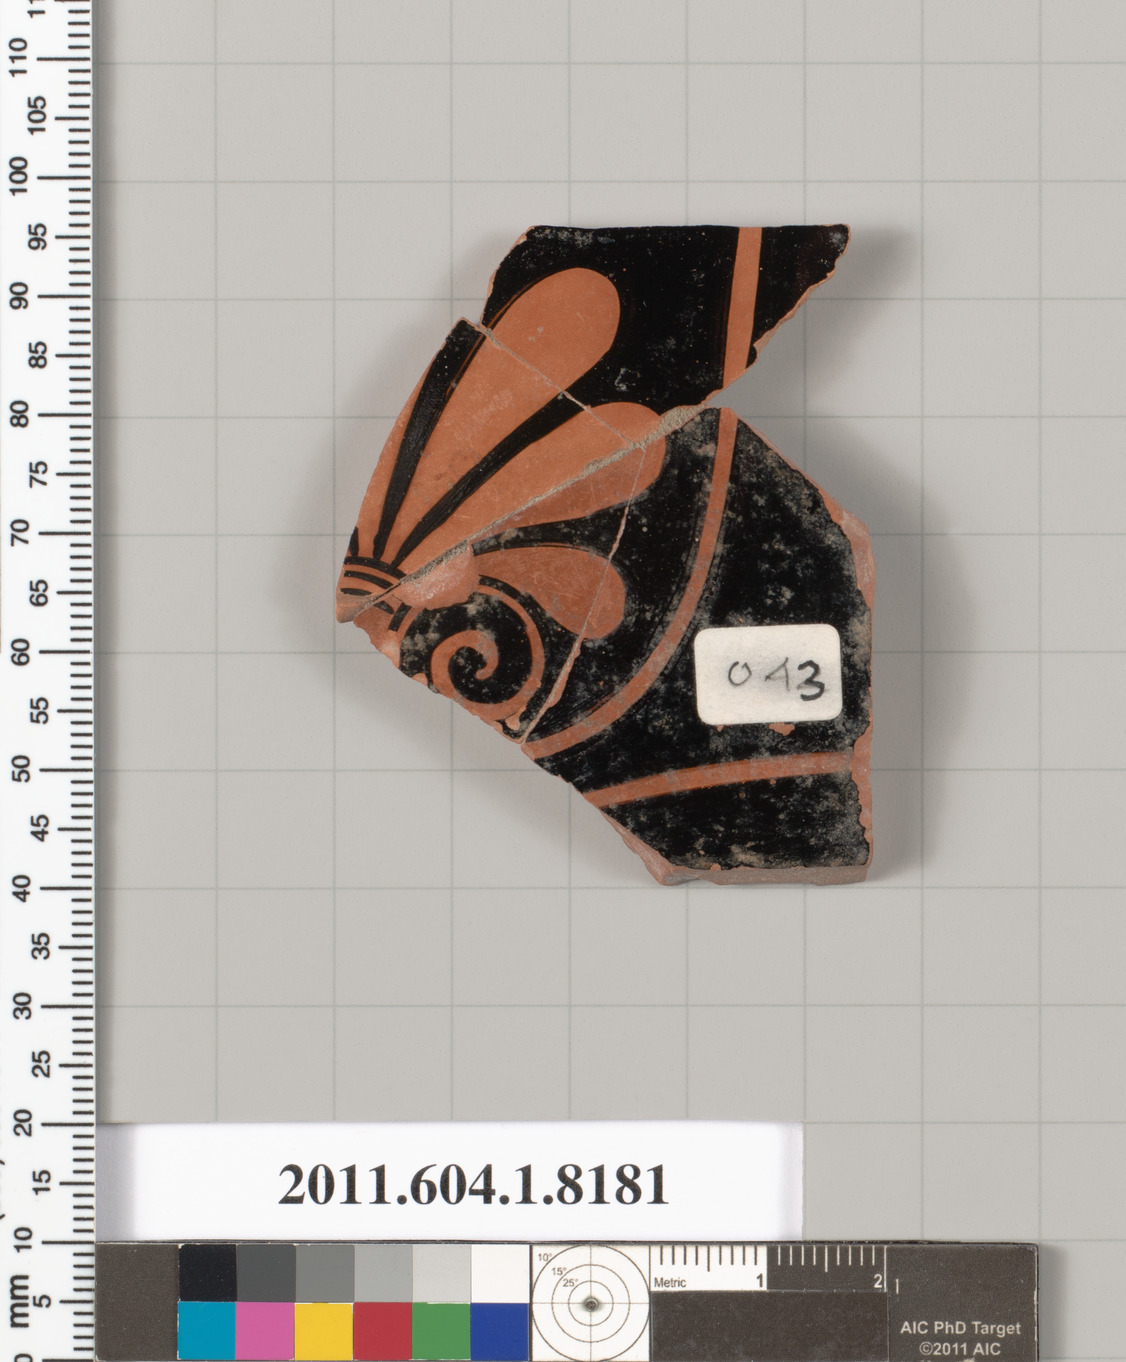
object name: kylix fragment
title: Terracotta fragment of a kylix (drinking cup)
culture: greek, attic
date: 520-510 BCE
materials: terracotta